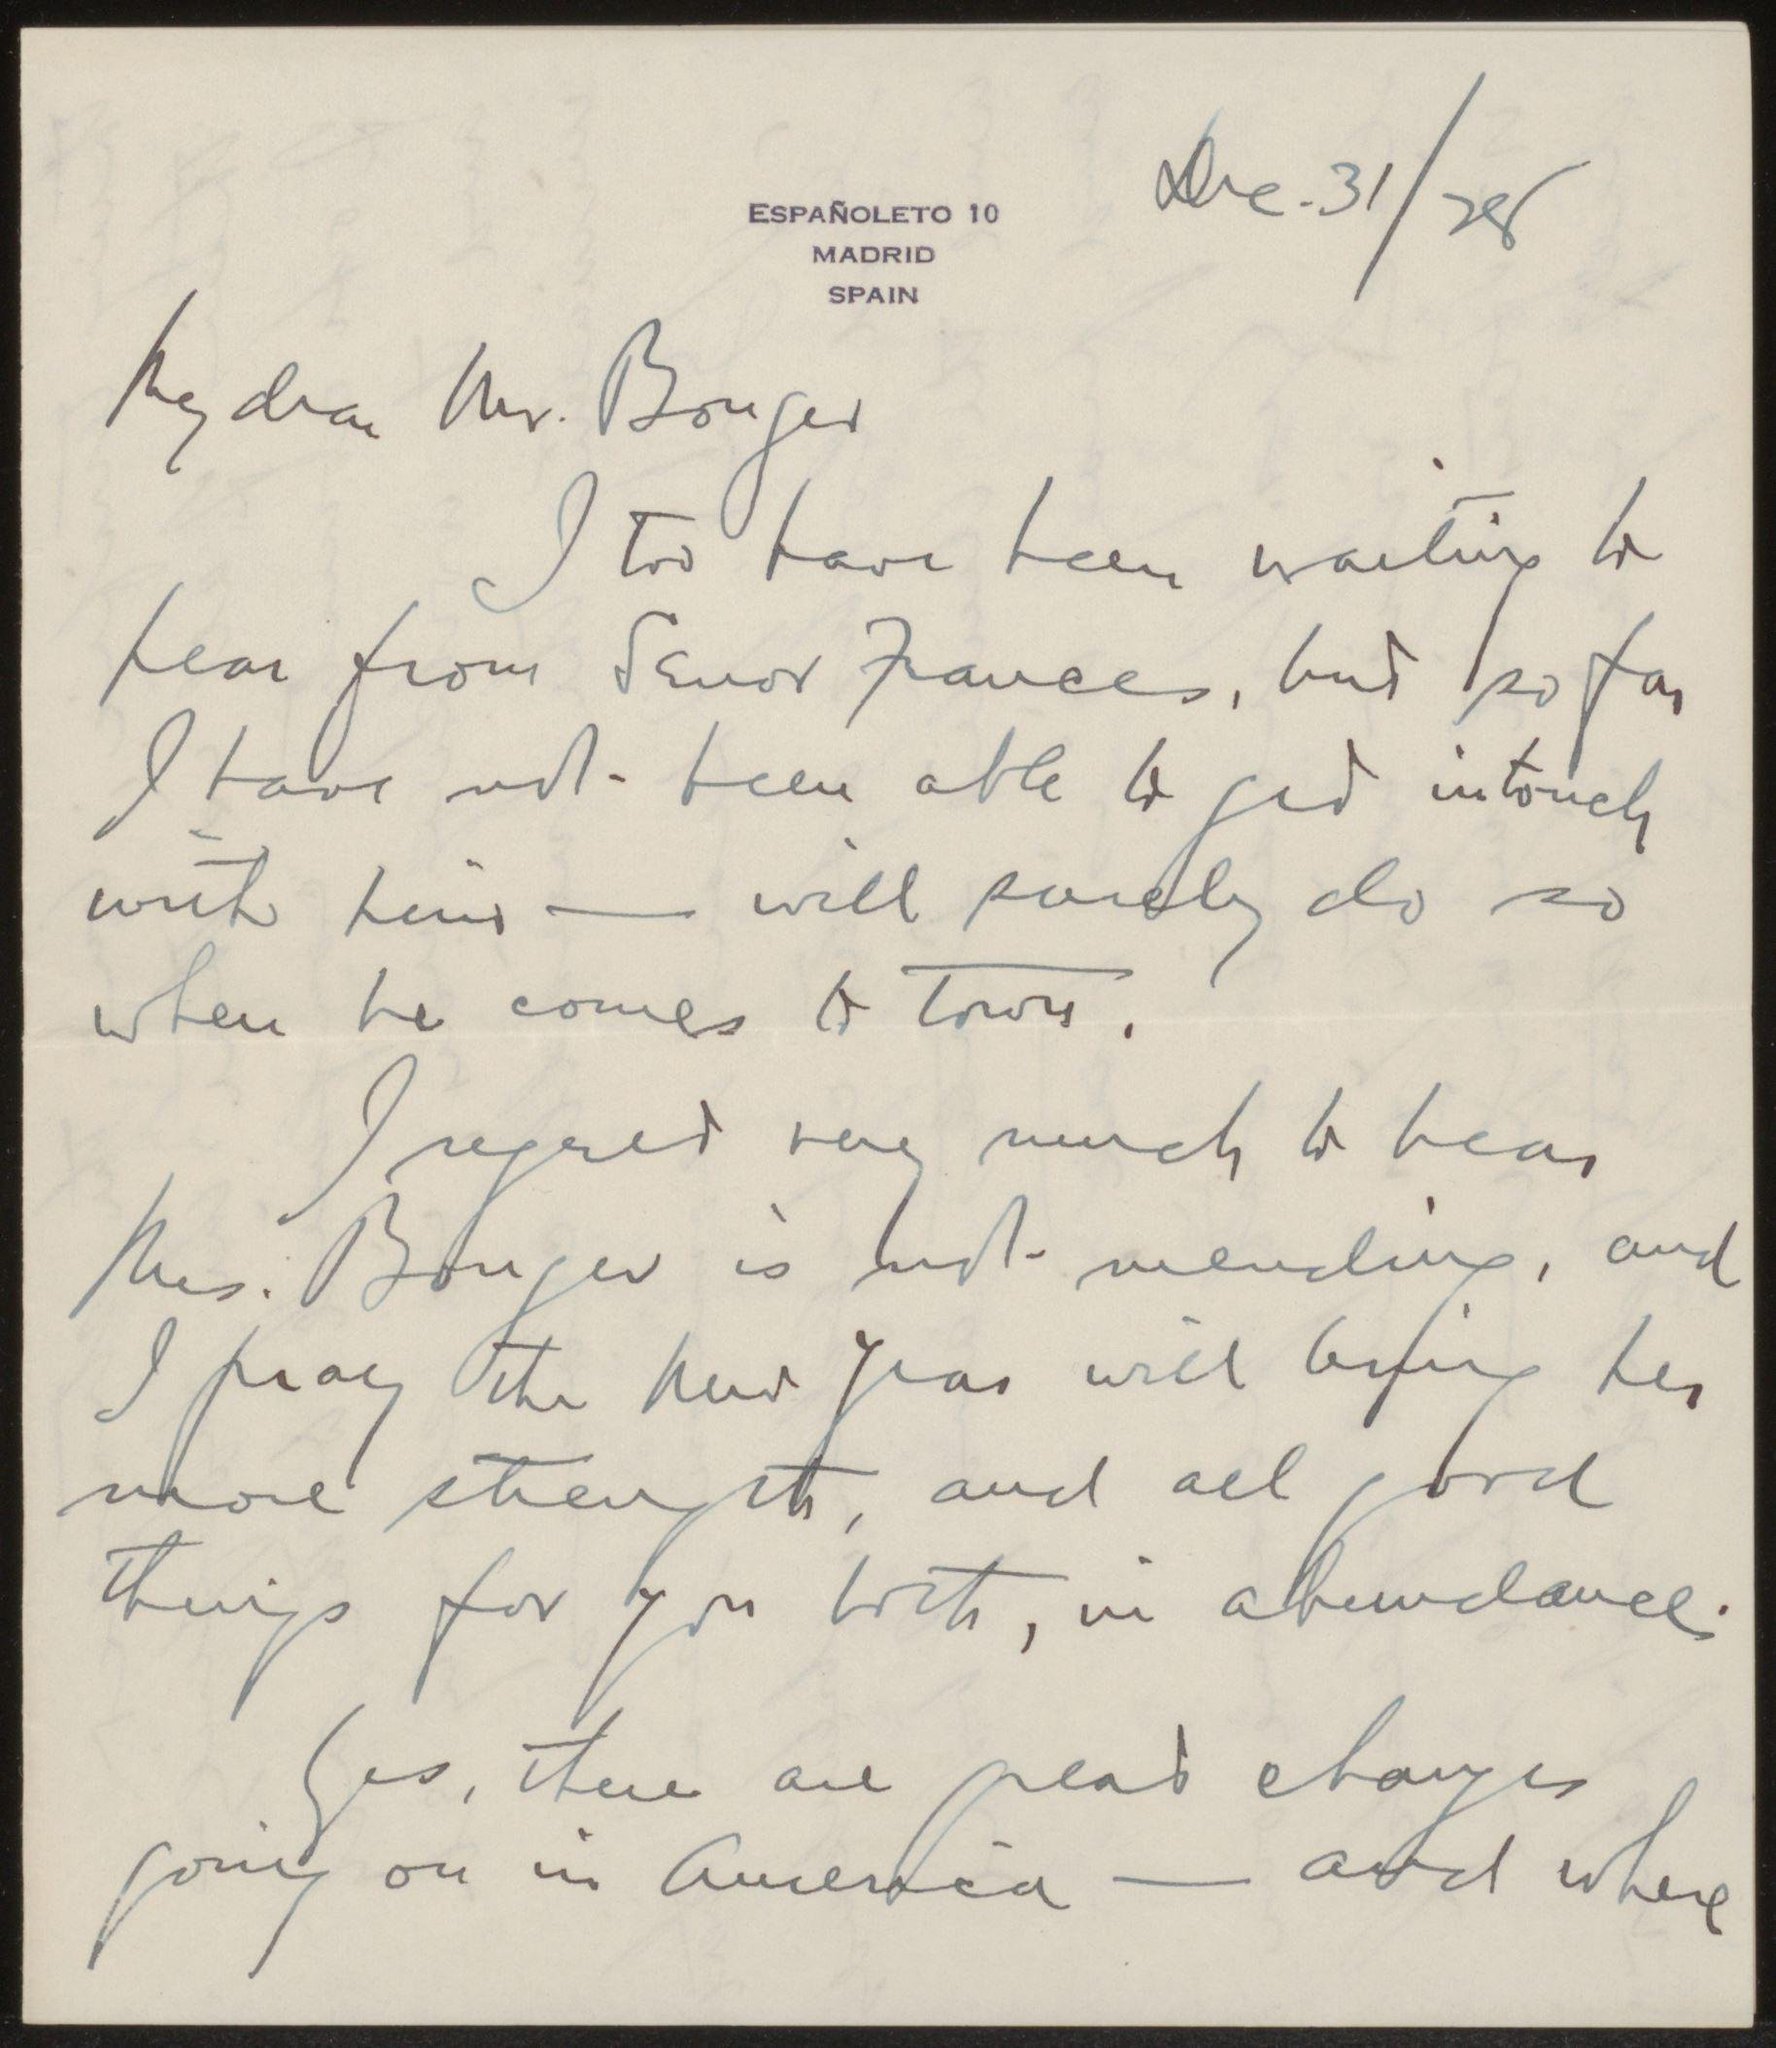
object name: letter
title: Brief aan Andries Bonger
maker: maurice fromkes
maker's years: 1872-1931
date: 1928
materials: ink, paper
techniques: pen, printing, writing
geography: madrid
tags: amsterdam, andries bonger, painting (including book-illumination, miniature-painting)